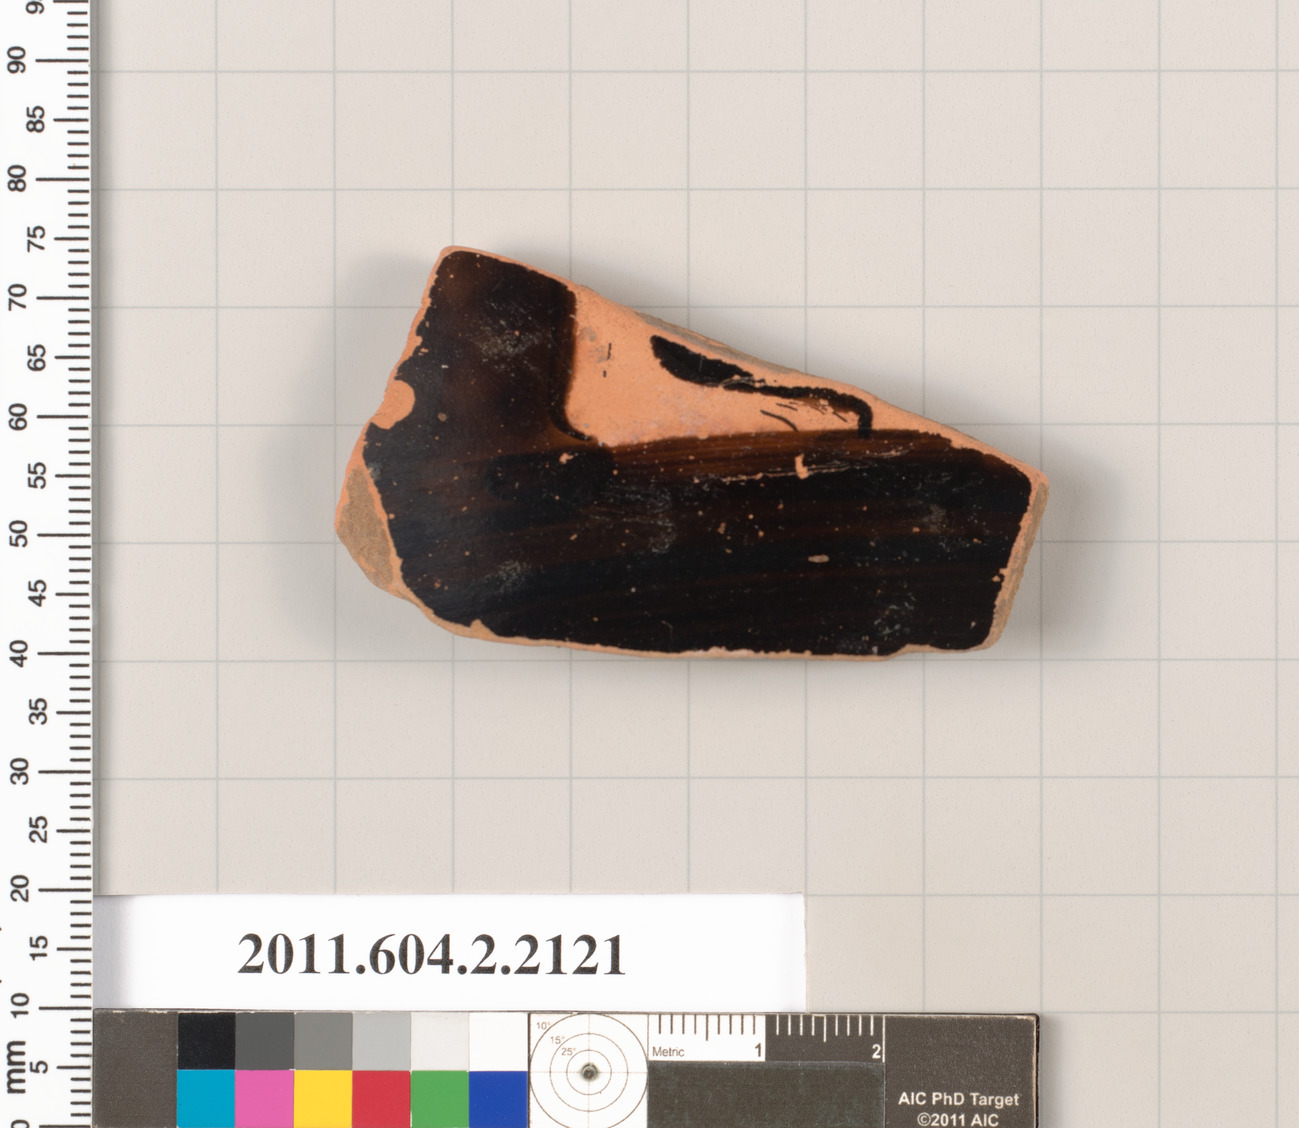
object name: krater fragment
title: Terracotta fragment of a krater (bowl for mixing wine and water)?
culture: greek, attic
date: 475-451 BCE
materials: terracotta